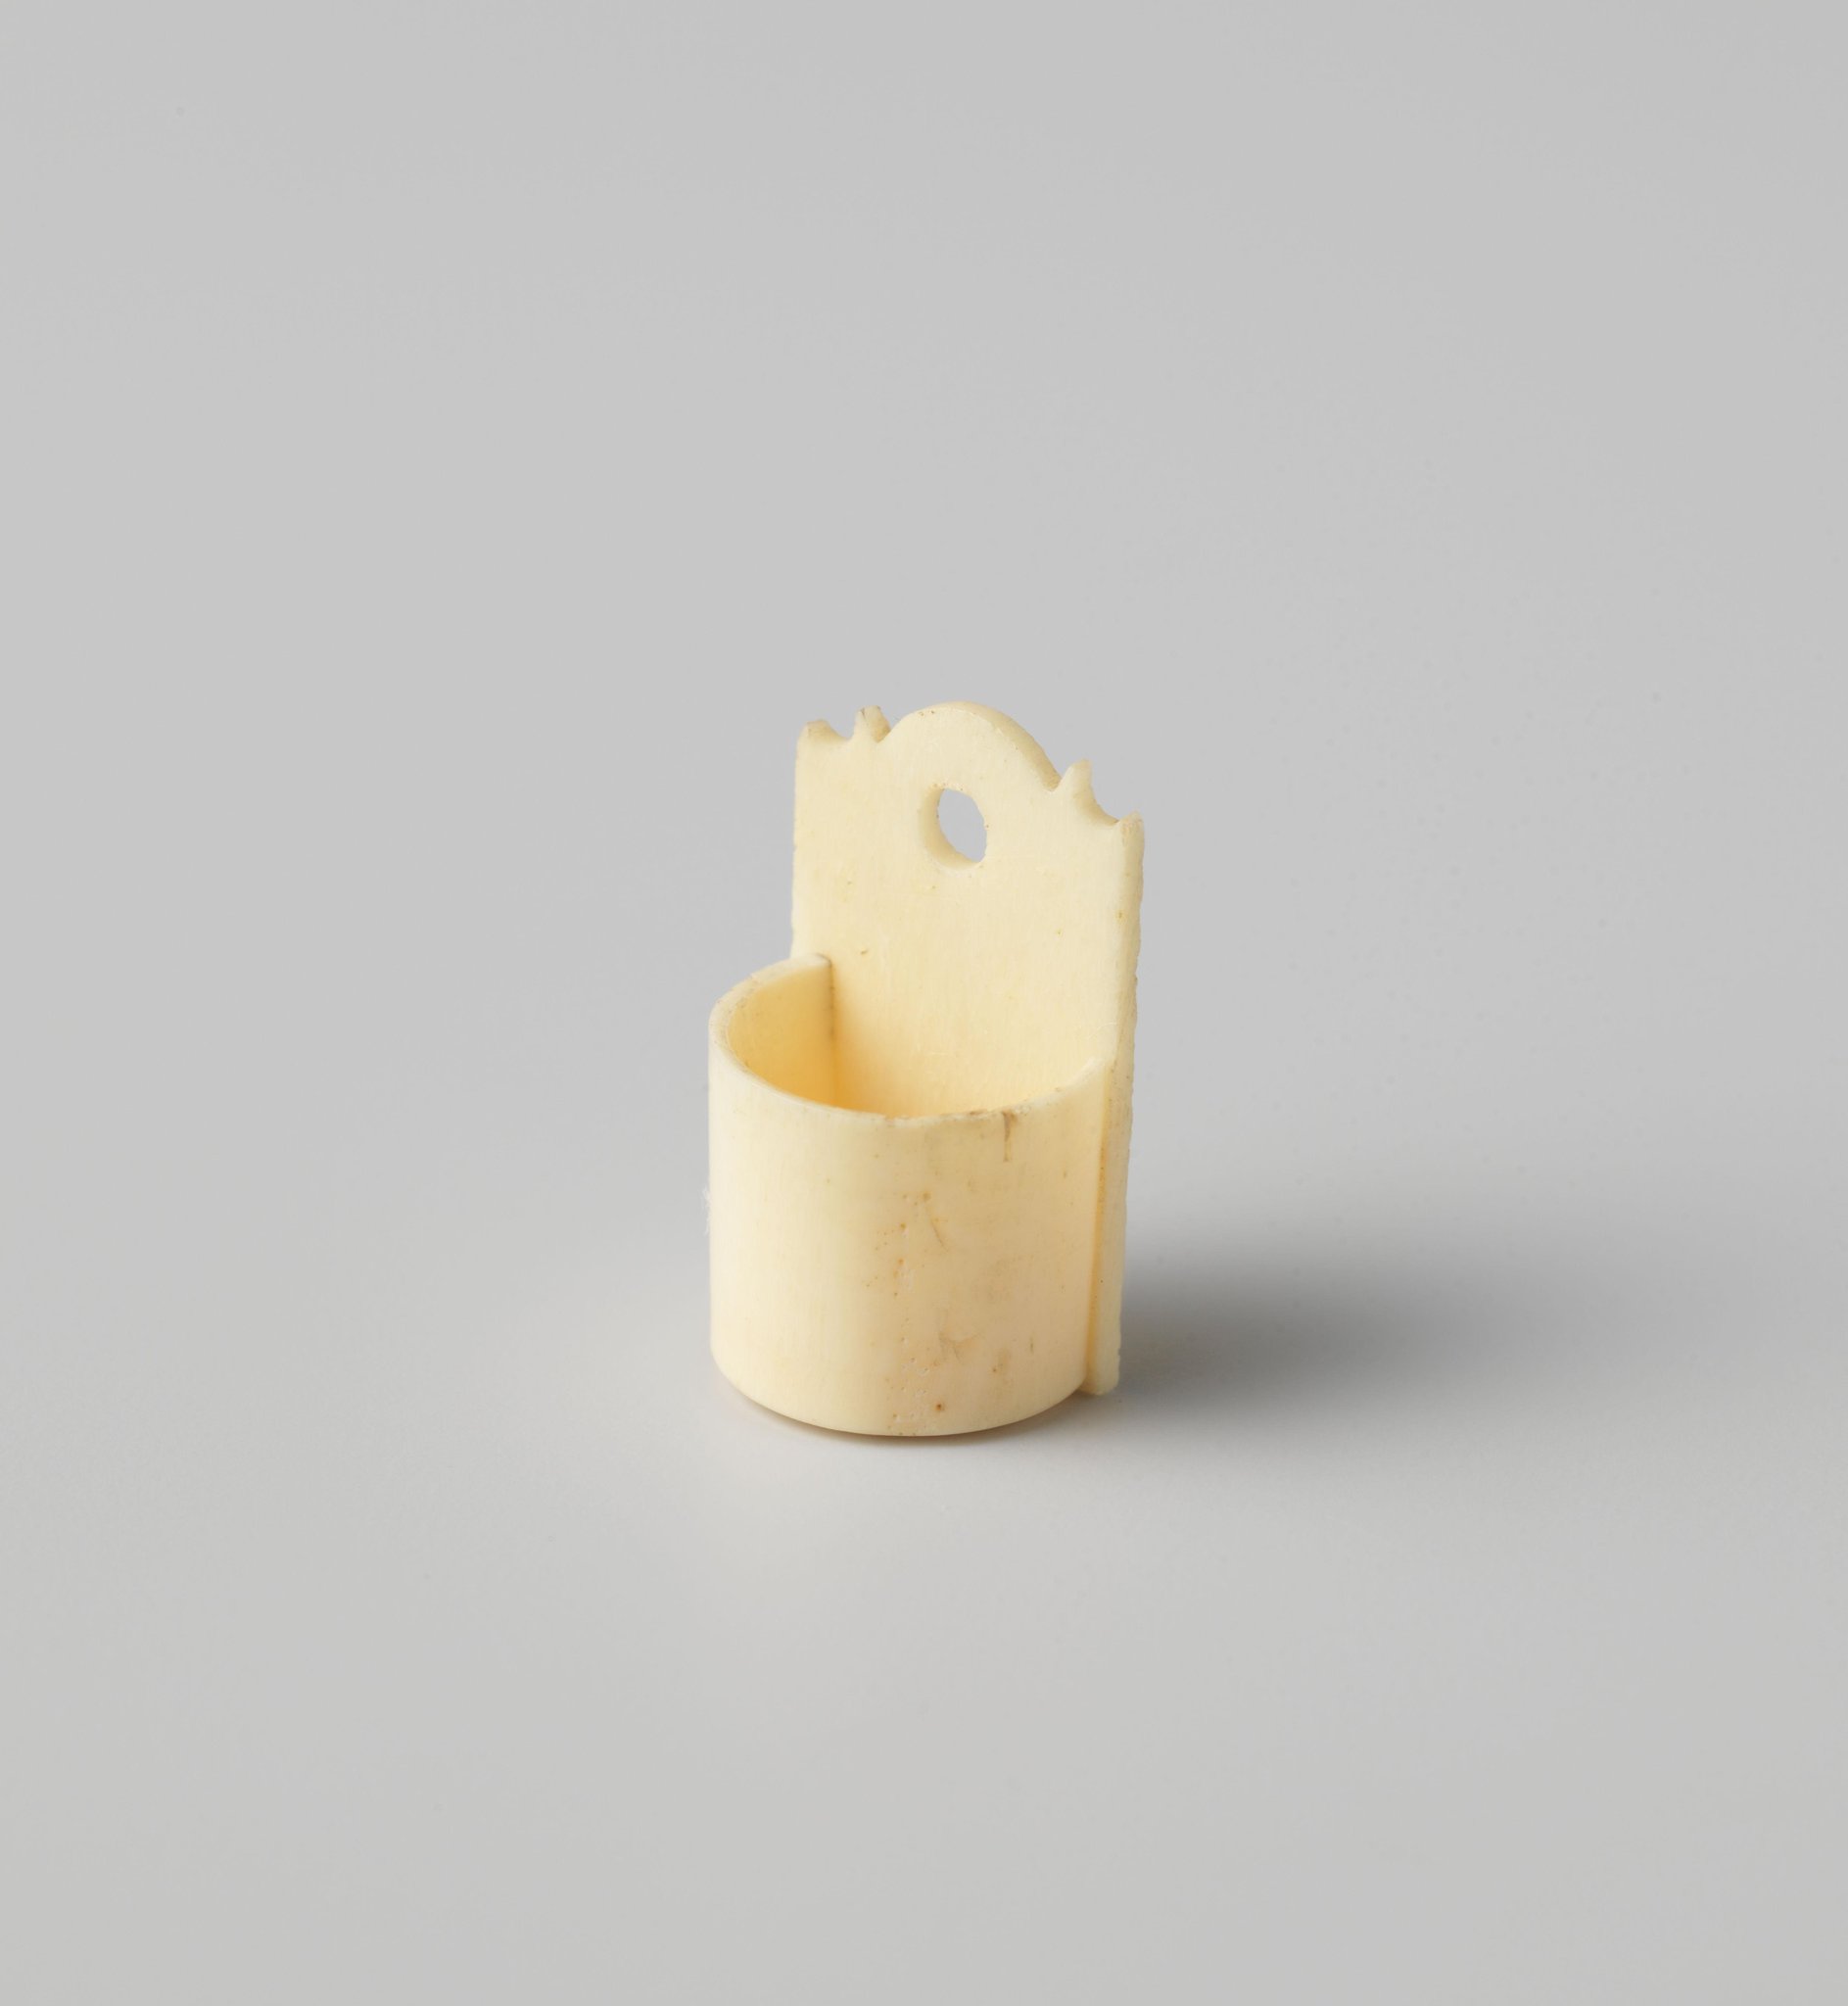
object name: container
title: Wandbak, halfrond, de achterplaat met profielversiering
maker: Anonymous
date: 1700-1799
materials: ivory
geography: germany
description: Een wandbak van ivoor, halfrond, achterplaat met profielversiering en oog om op te hangen.